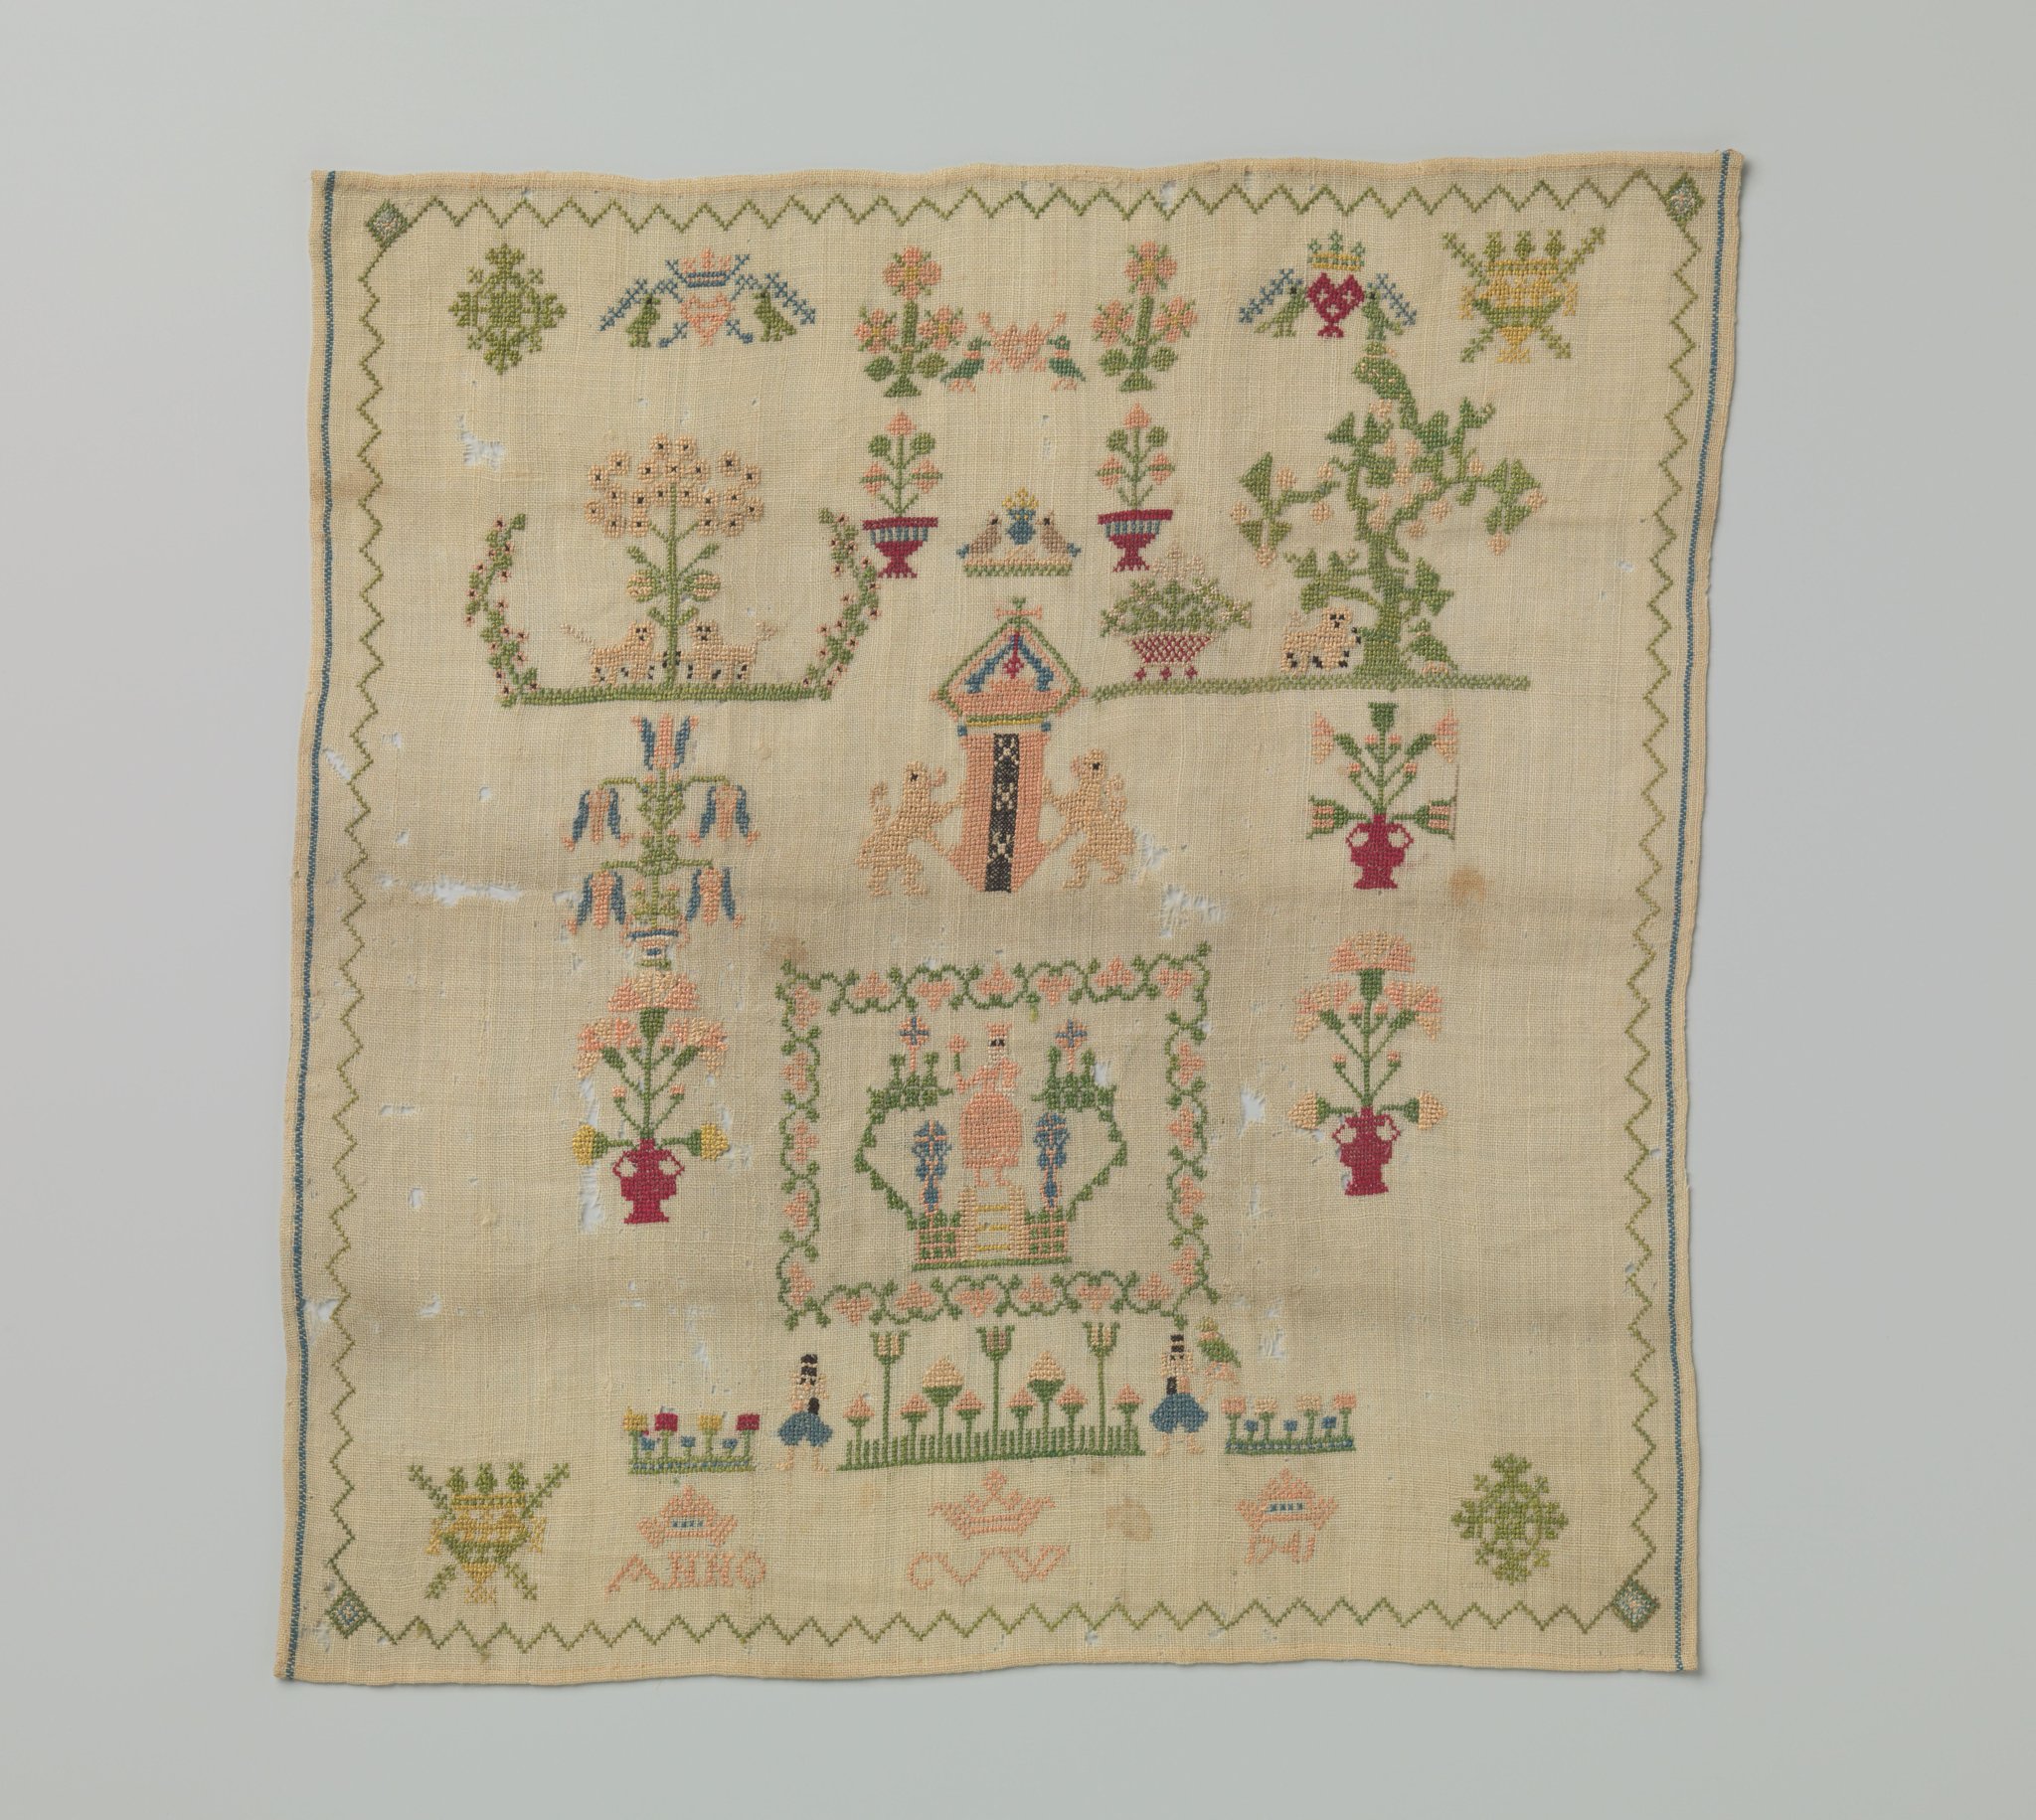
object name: merkdoek, merklap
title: Merklap van veelkleurige zijde op wollen mousseline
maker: Anonymous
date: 1741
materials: silk, wool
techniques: embroidered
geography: amsterdam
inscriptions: date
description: Merklap van zijde op wol. Het borduurwerk heeft het wapen van Amsterdam, de initialen CVW, de datering ANNO 1741, de Nederlandse maagd in de Hollandse tuin, honden, bomen en bloempotten.